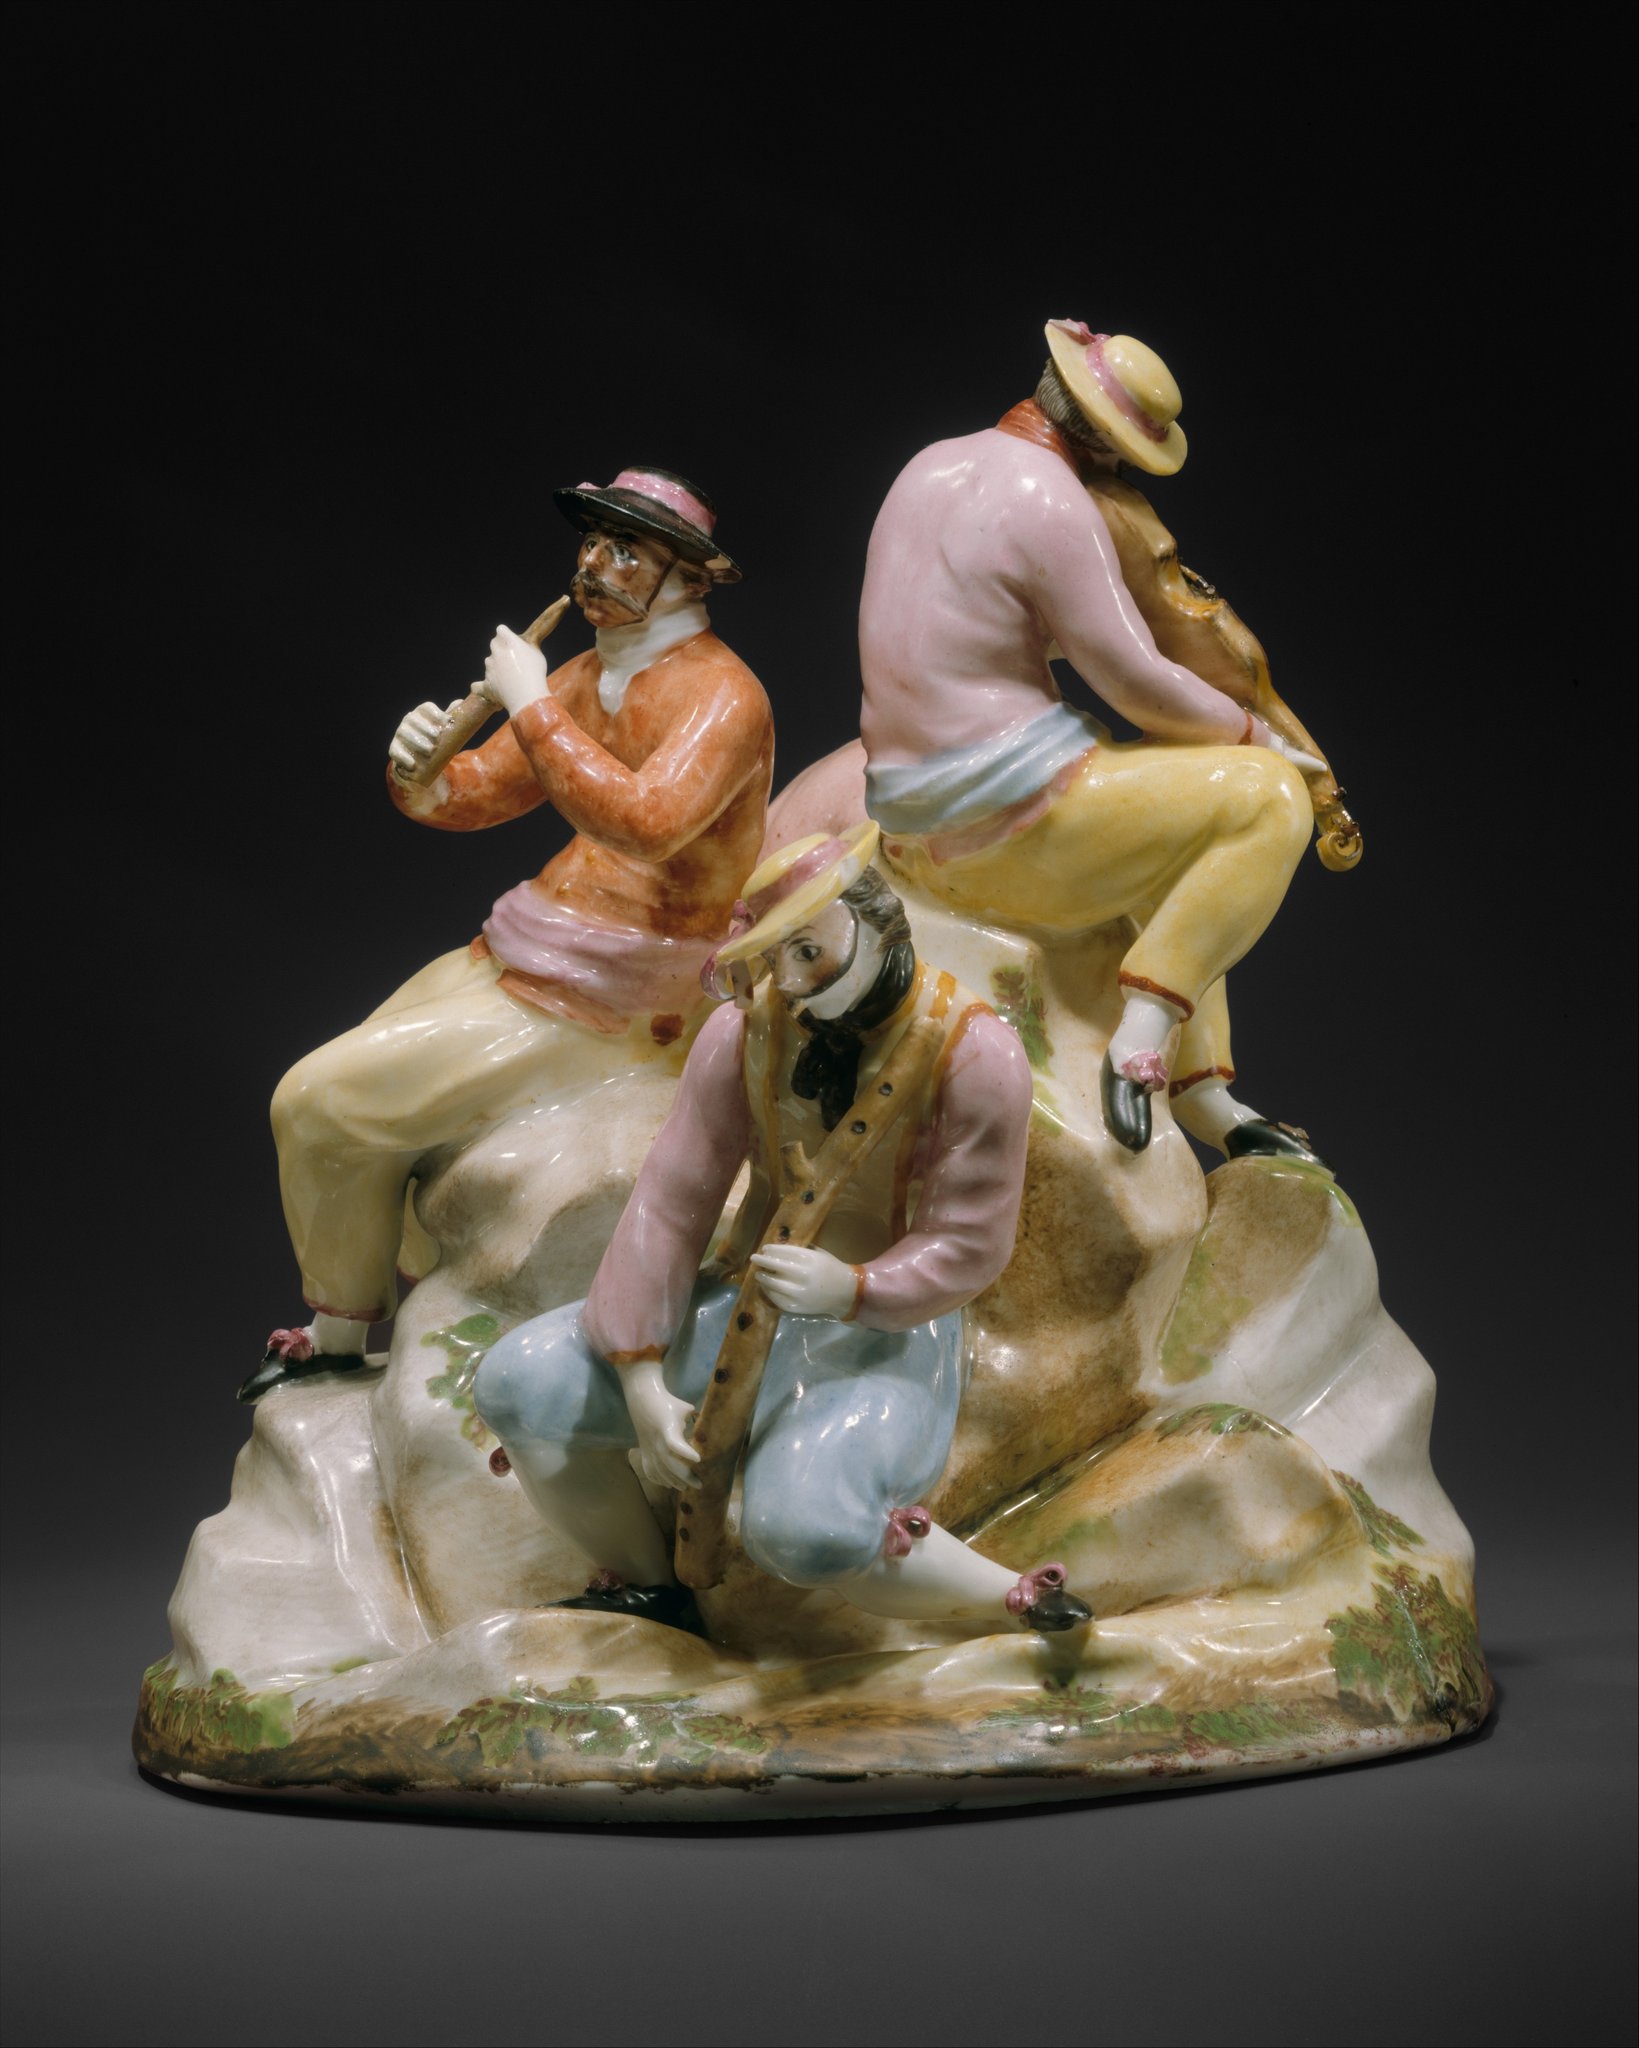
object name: group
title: Four carnival musicians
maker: zurich pottery and porcelain factory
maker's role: factory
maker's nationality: swiss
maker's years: 1763-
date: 1770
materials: soft paste porcelain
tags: musical instruments,men,musicians